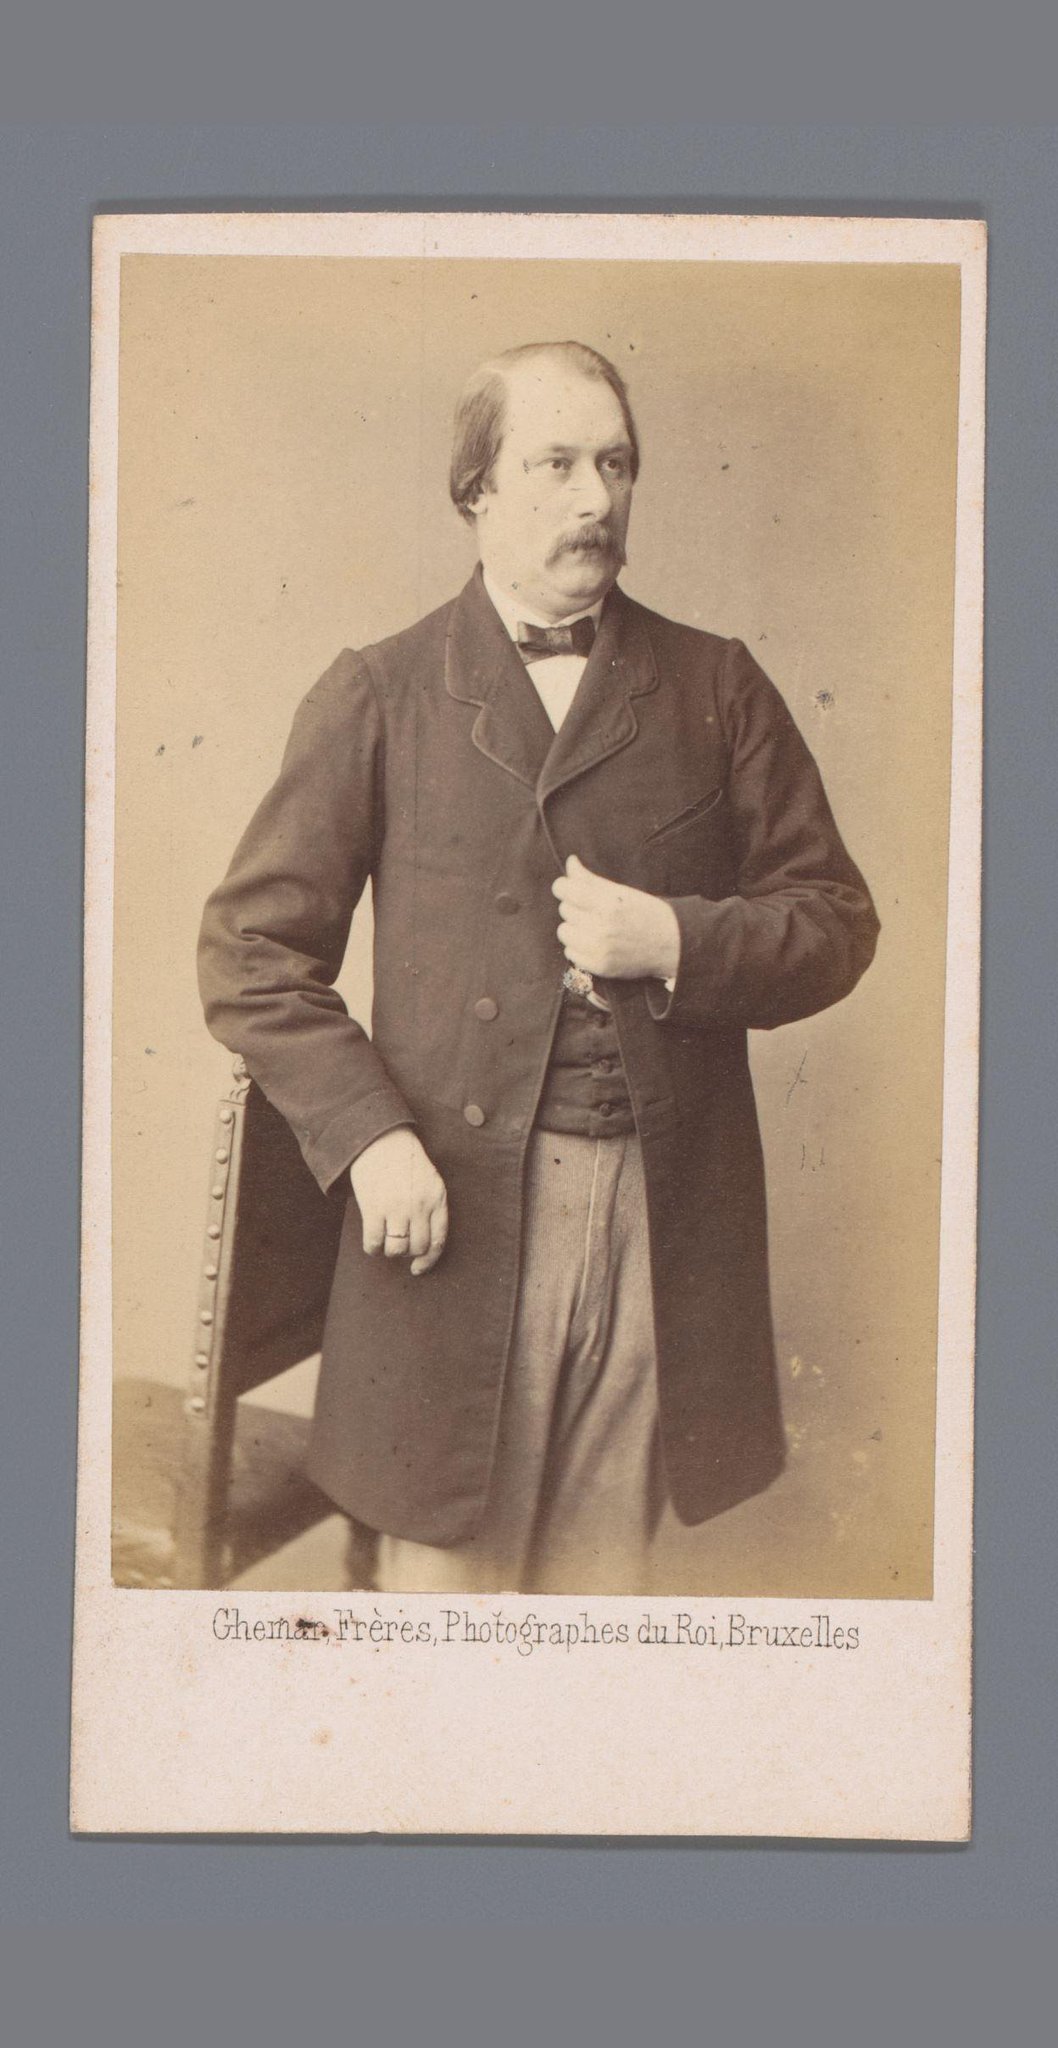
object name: photograph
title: Portret van een onbekende man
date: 1859-1894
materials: cardboard, paper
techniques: albumen print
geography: brussels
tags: adult man, anonymous historical person portrayed, brussels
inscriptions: inscription: ‘Atelier de photographie./ Ghémar Frères,/ Photographes du roi,/ 27, Rue de l'Ecuyer,/ entrée par la porte cochère,/ Bruxelles.’, inscription: ‘Ghemar Frères, Photographes du Roi, Bruxelles’